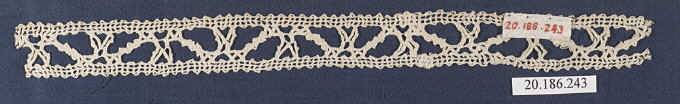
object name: insertion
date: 1701-1900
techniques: lace